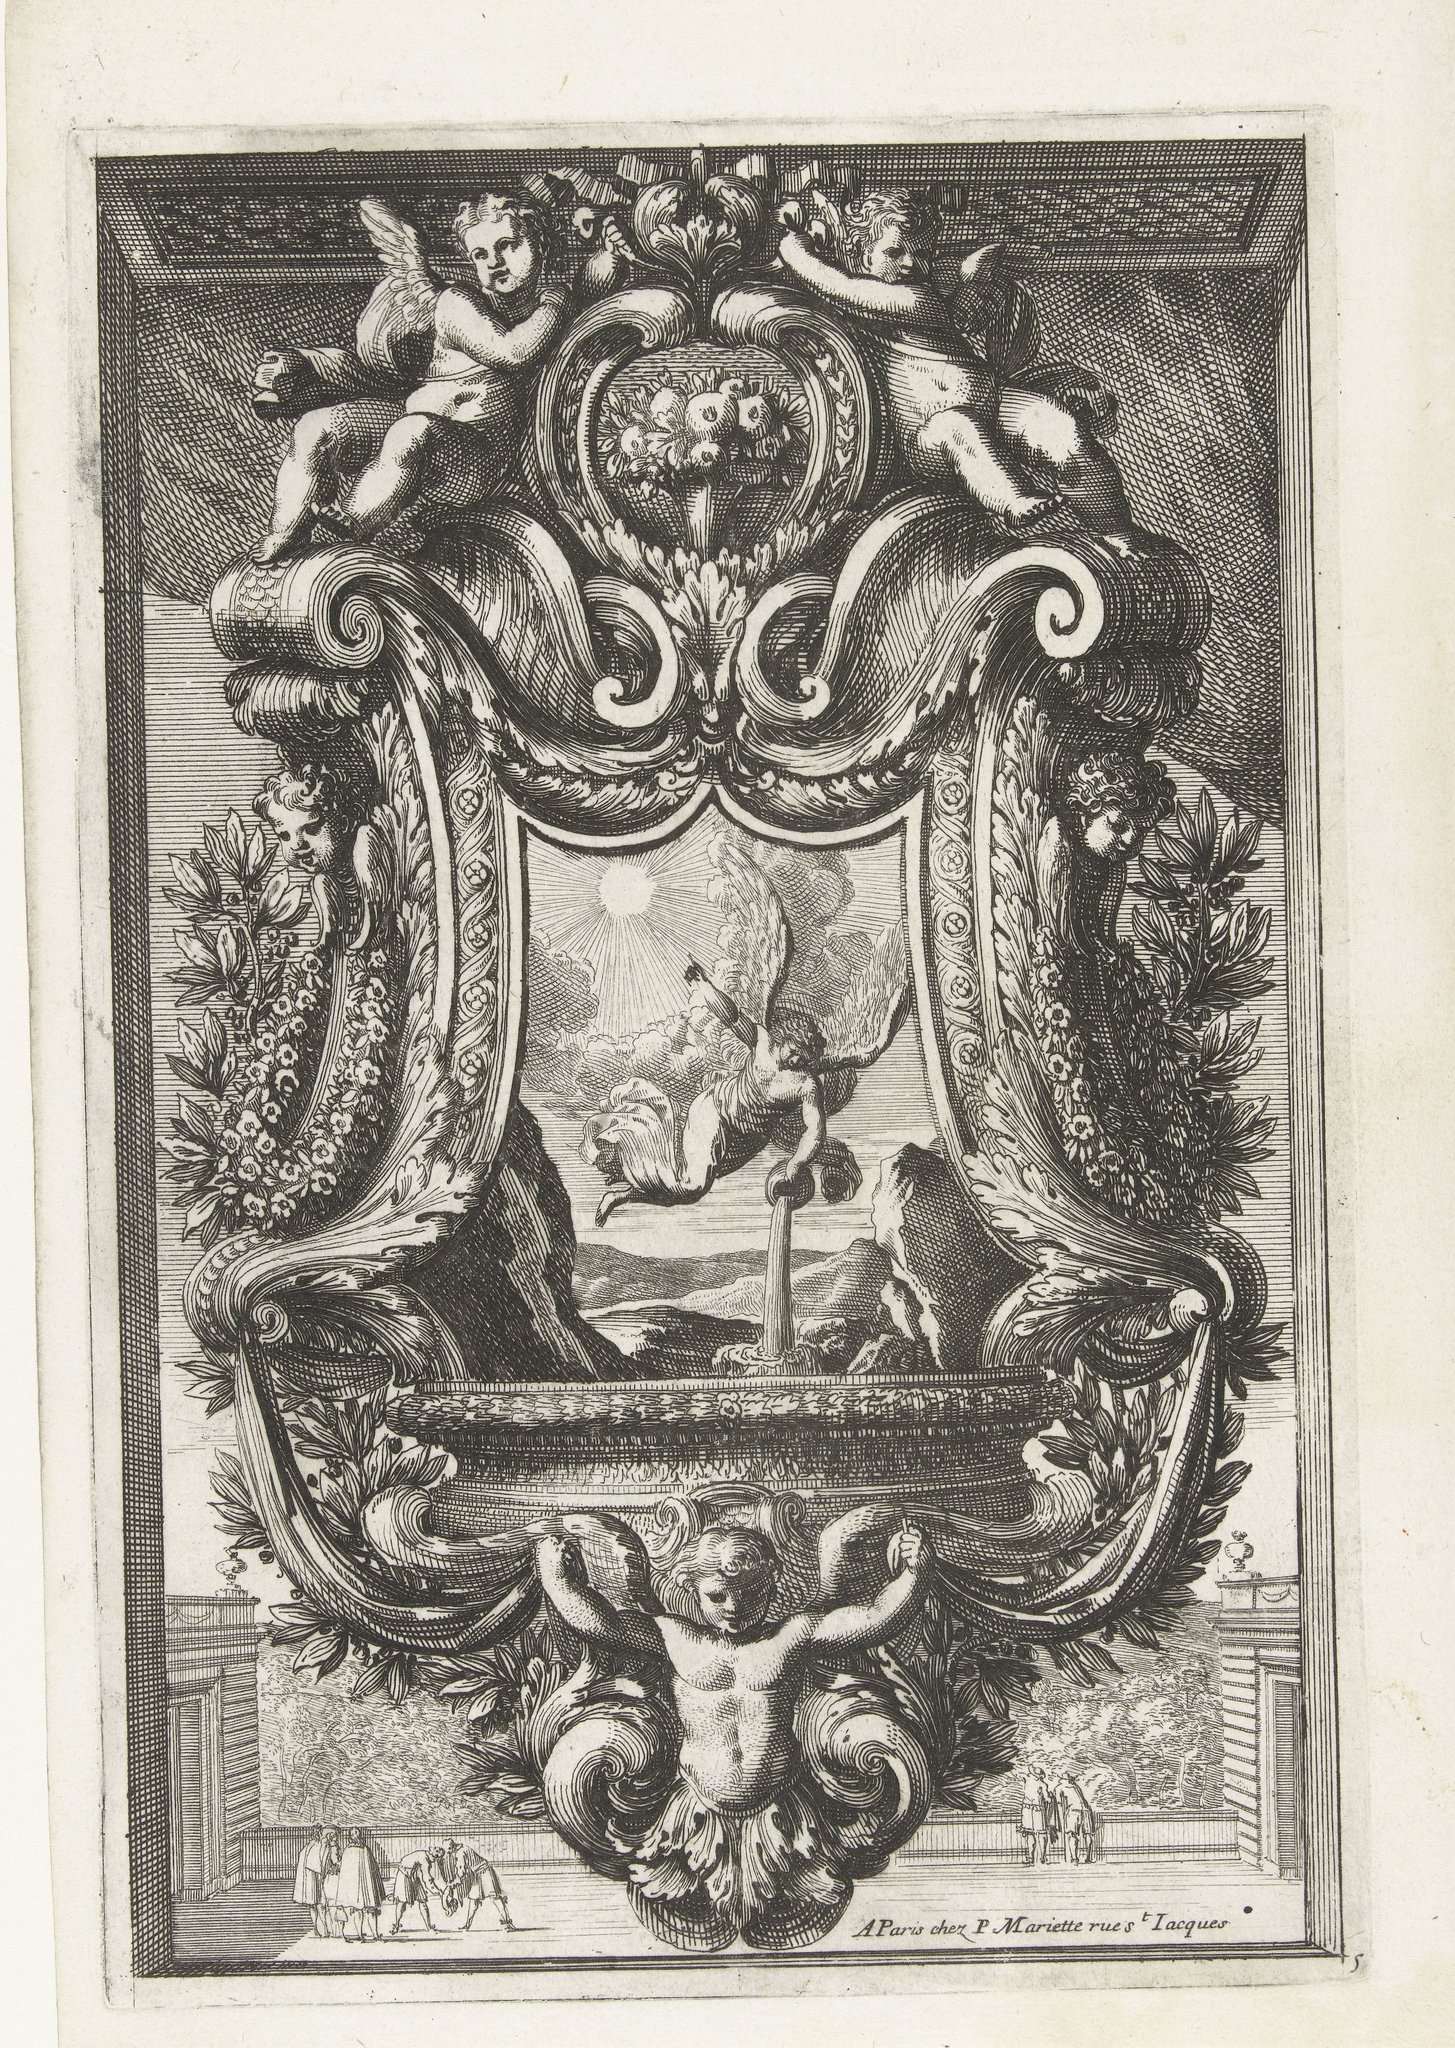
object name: print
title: Inuentions pour faire des plaques ou des Aubenistiers seruans aux Orfeures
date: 1659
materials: paper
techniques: etching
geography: france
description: In de vorm van een rond bassin, gedragen door een putto. Op de achterplaat giet een engel water op een gebergte. Uit eerste editie.